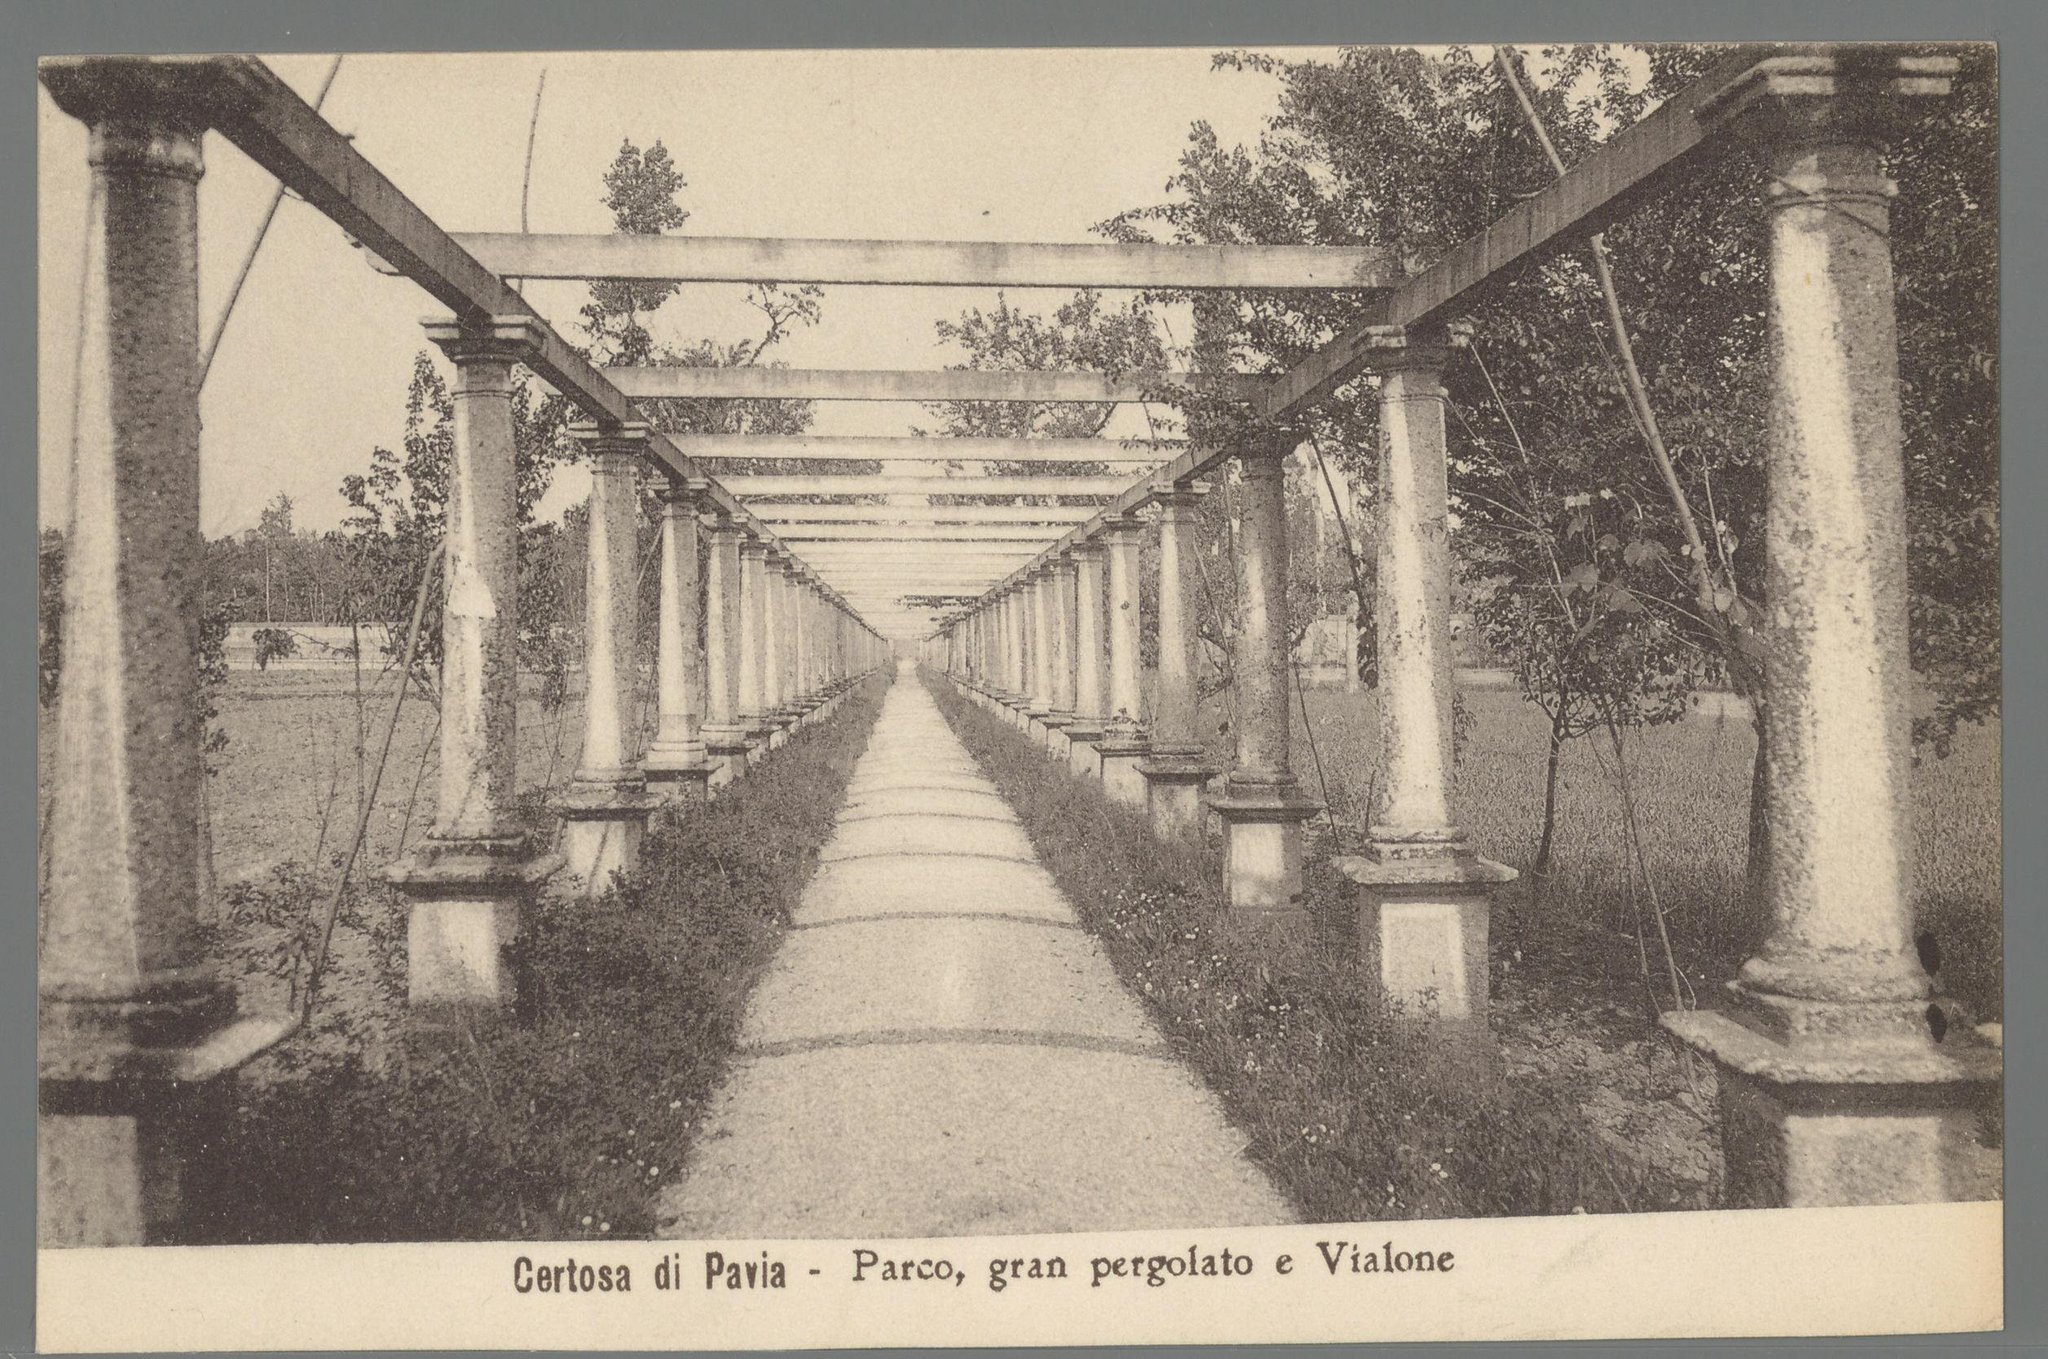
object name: photomechanical print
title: Certosa di Pavia. Parco, gran pergolato e Vialone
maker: Anonymous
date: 1908-1914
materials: cardboard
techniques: photograph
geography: milan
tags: park, pergola